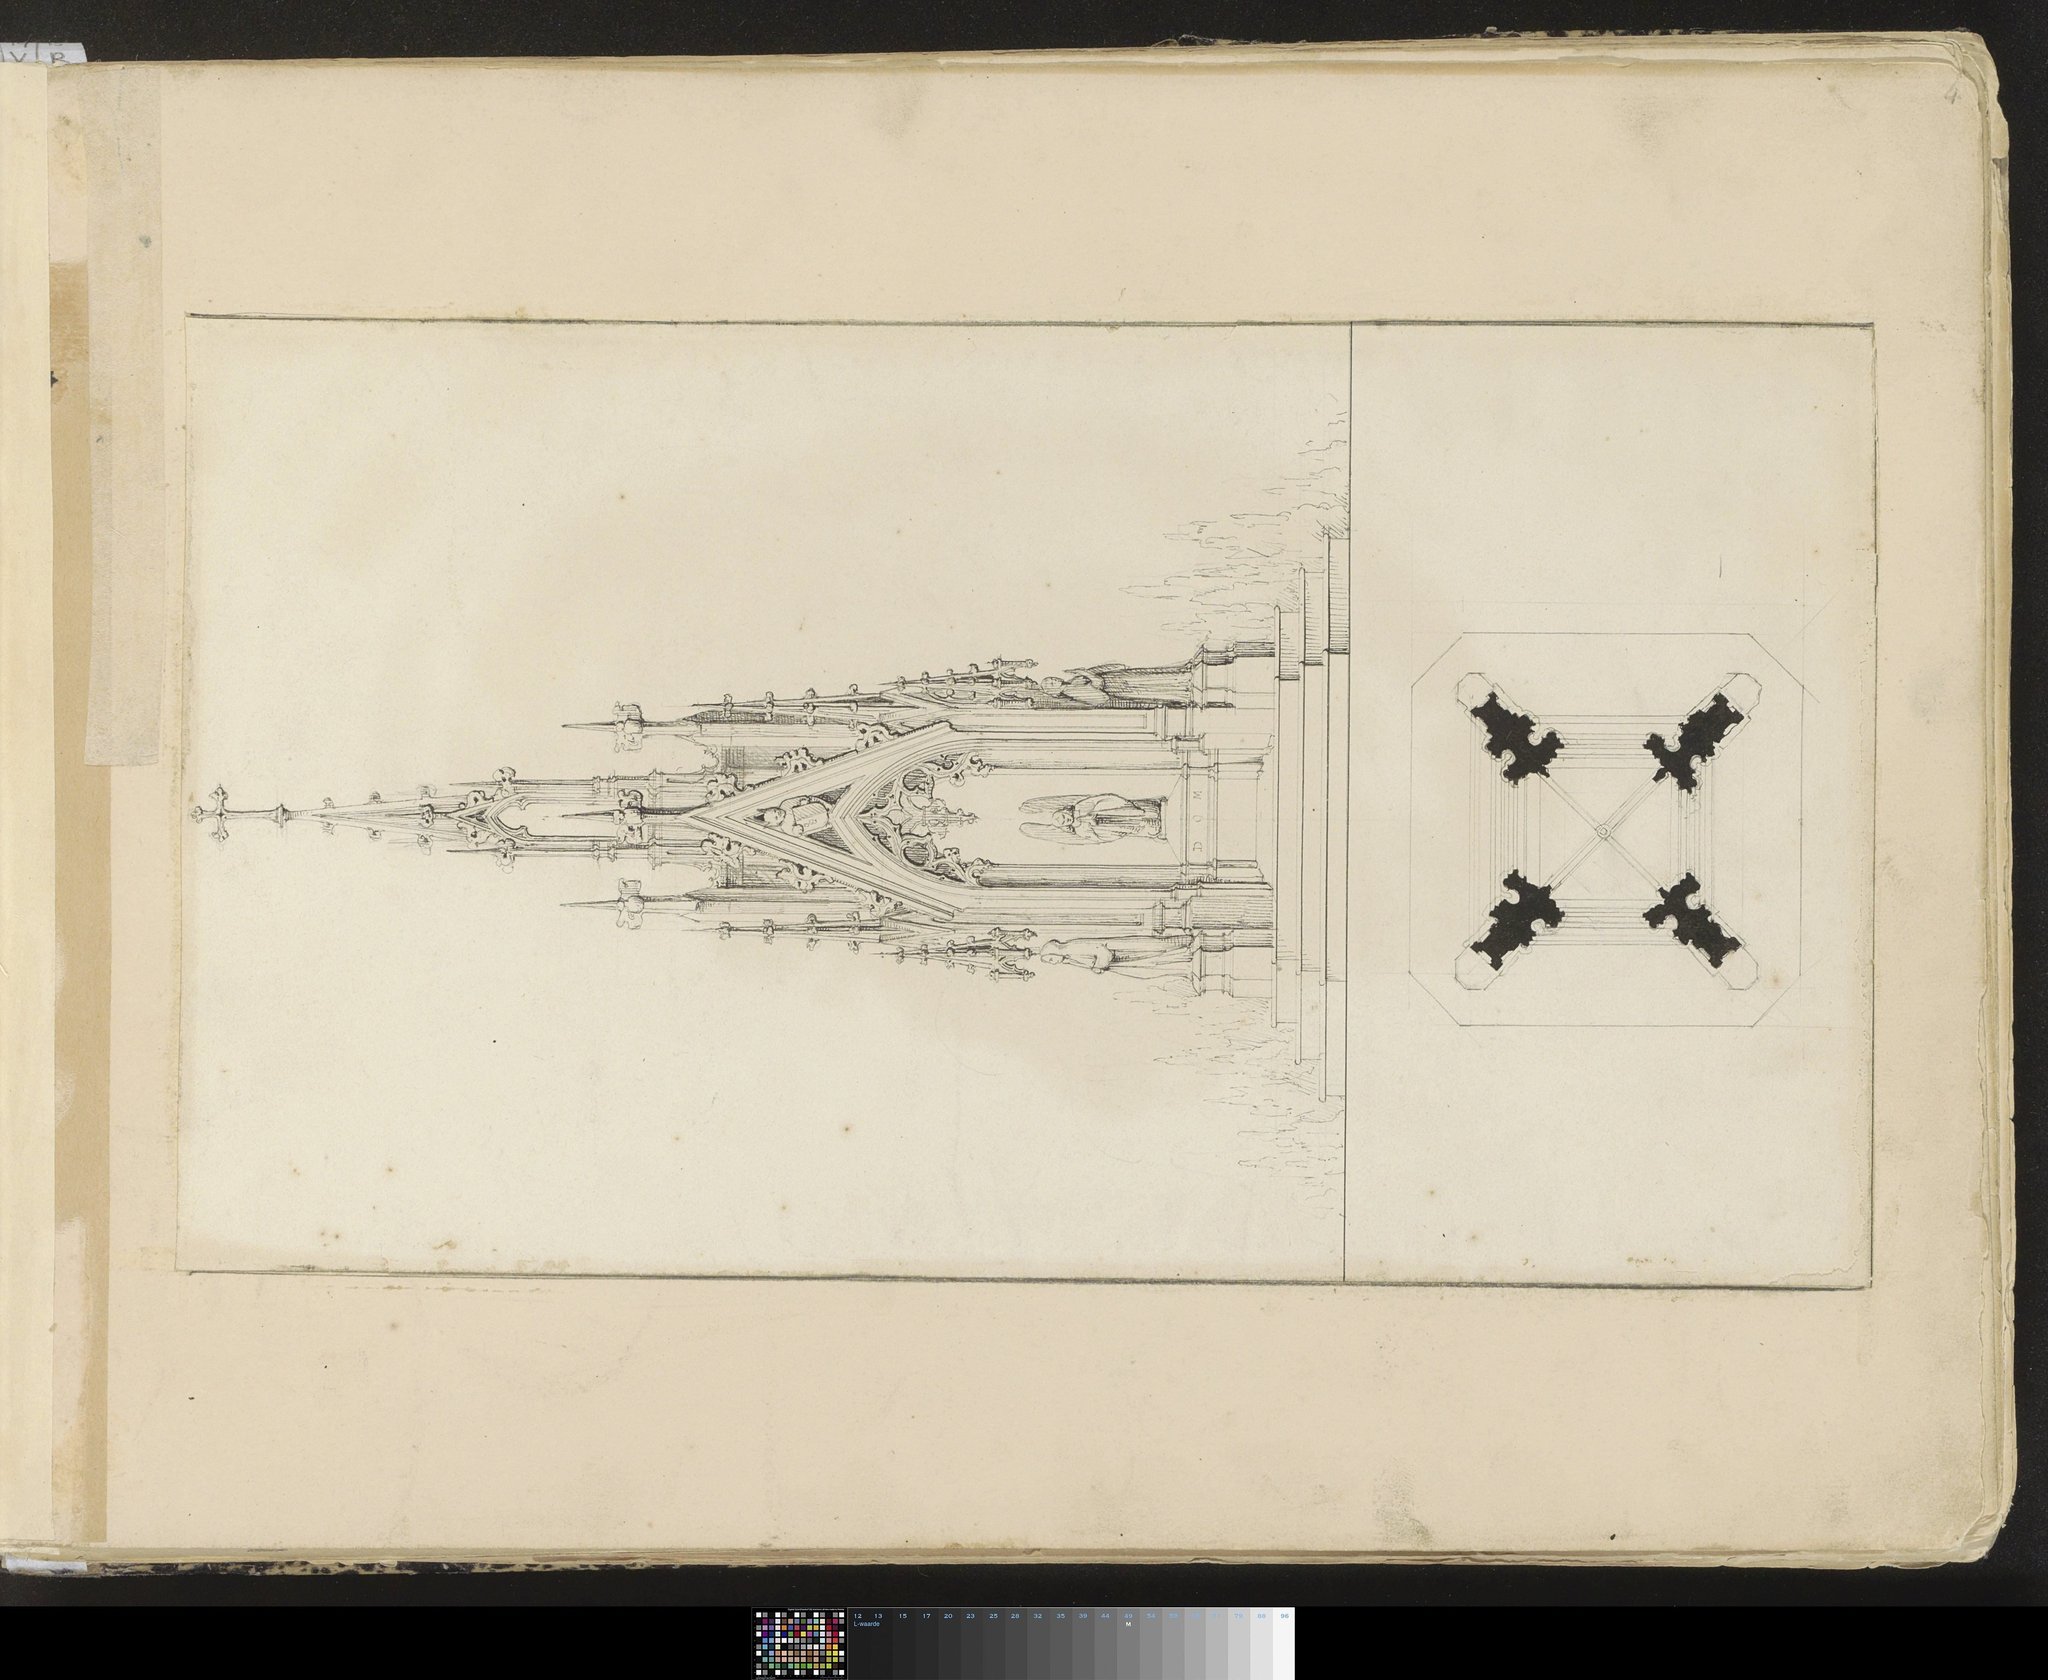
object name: sketchbook leaf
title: Gotisch monument met plattegrond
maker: pierre joseph hubert cuypers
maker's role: draughtsman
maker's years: 1827-1921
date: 1850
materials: ink, paper, pencil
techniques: pen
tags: monument, statue, plan ~ architecture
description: Blad 4 recto uit een schetsboek met 37 bladen.